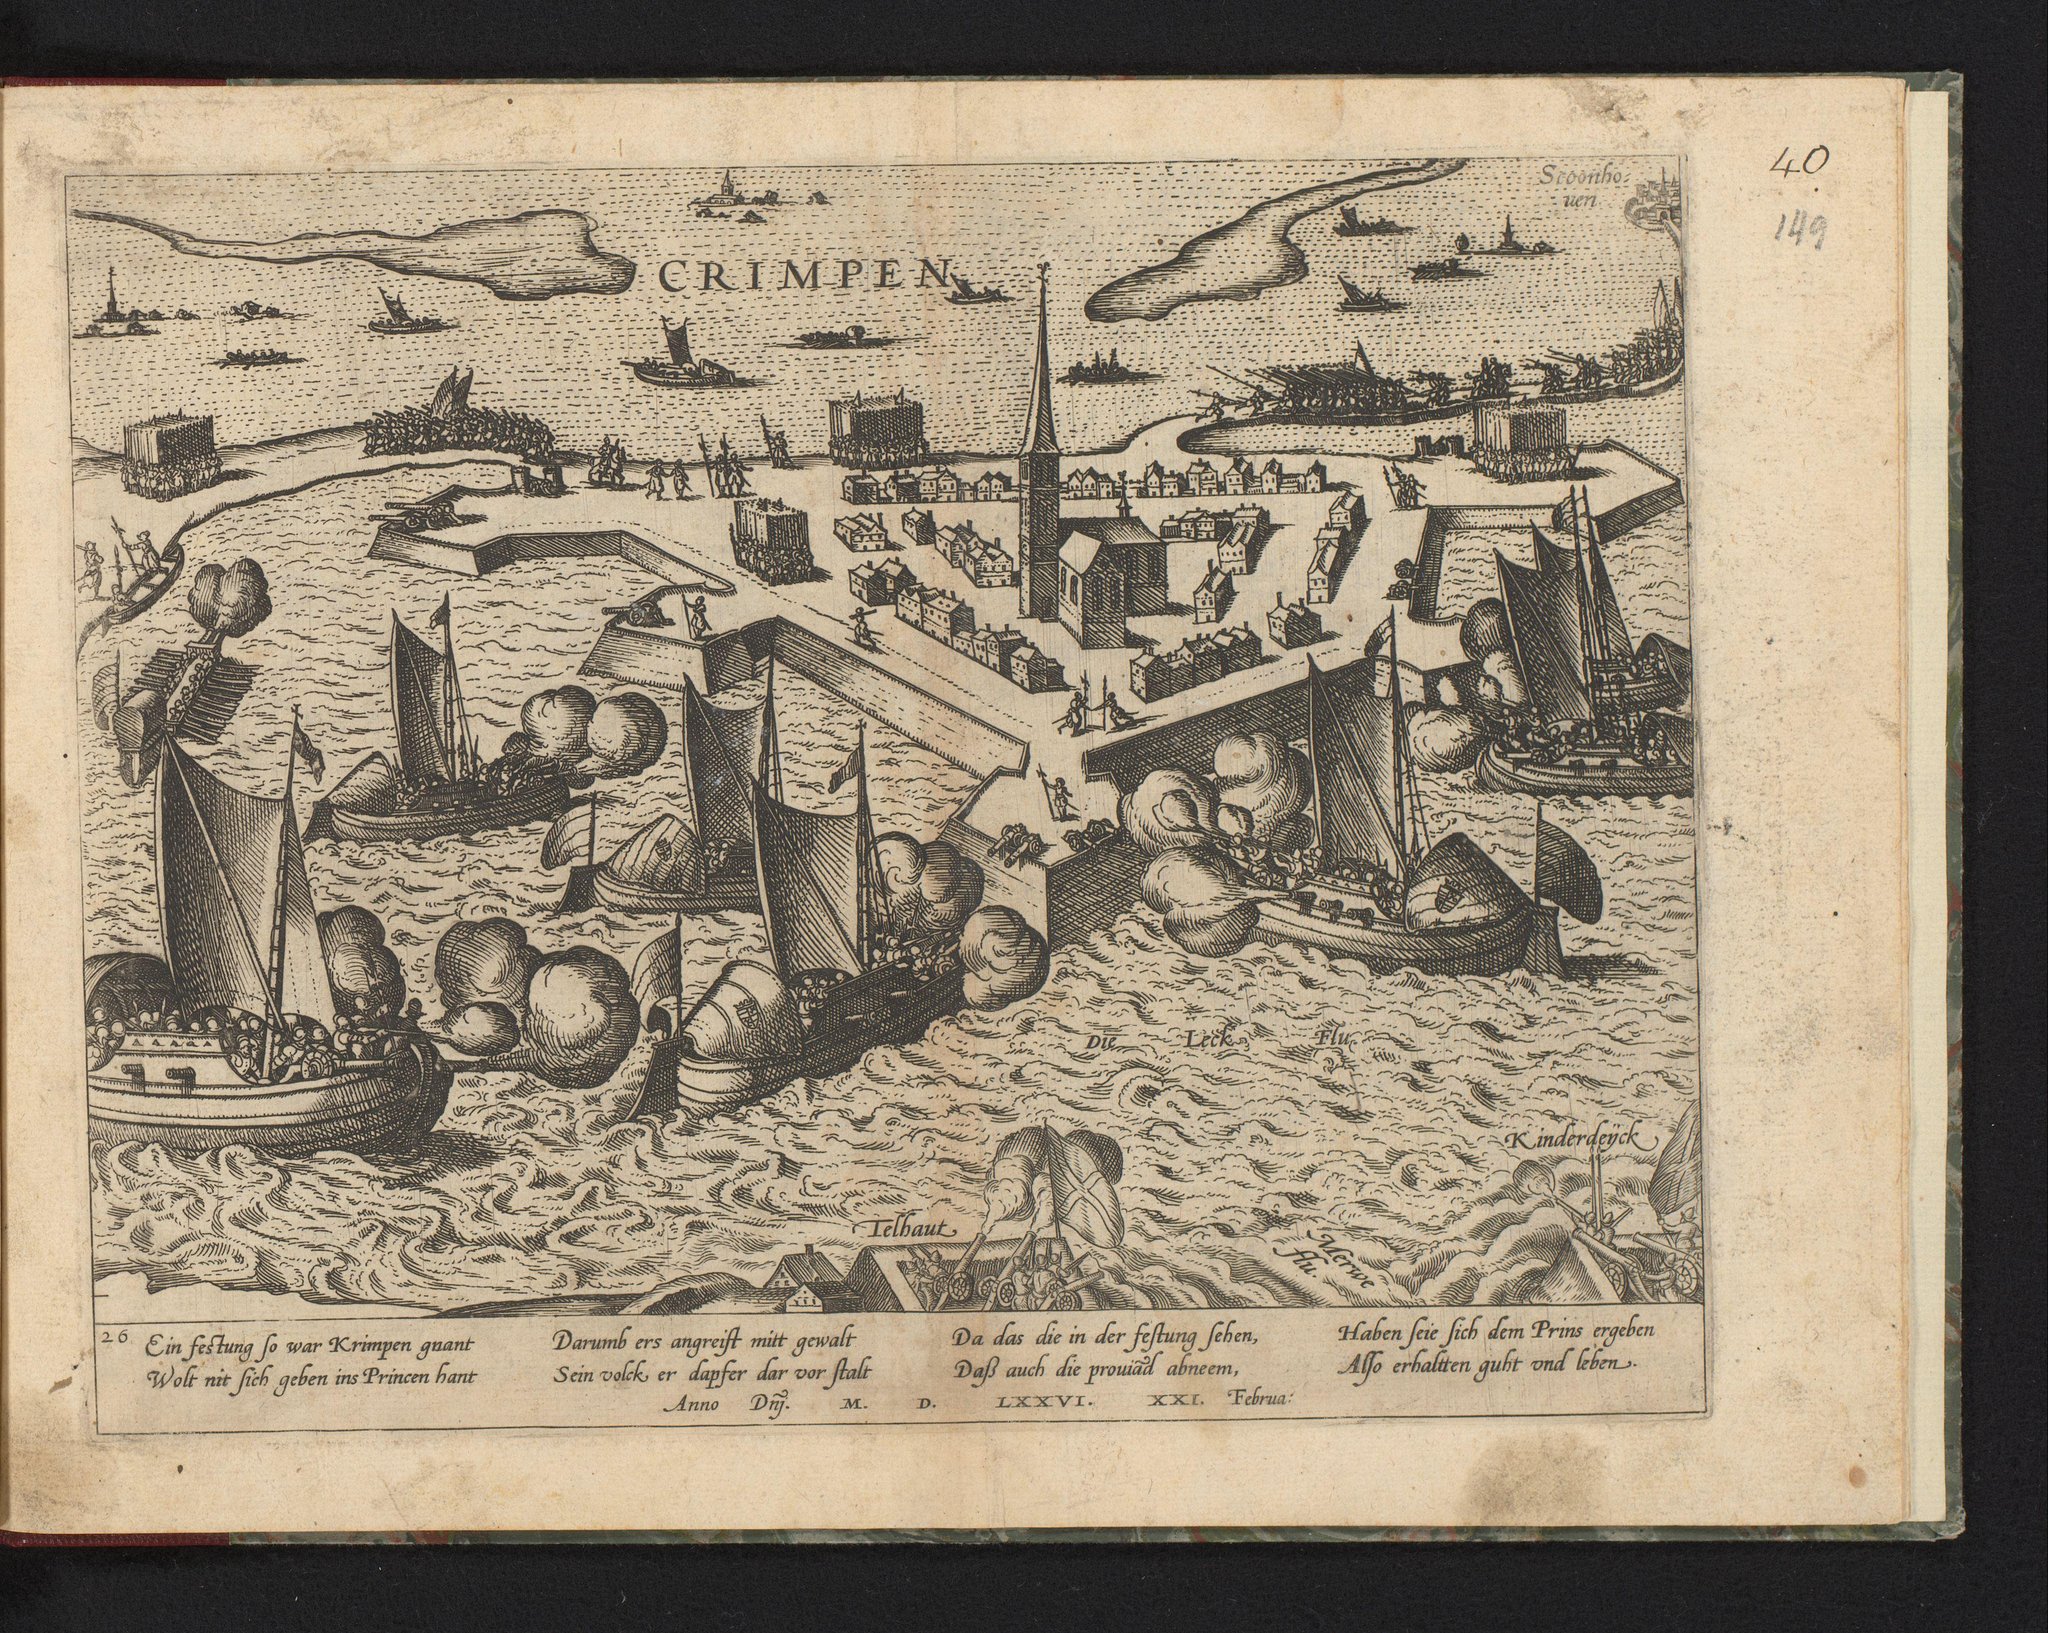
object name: print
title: Inname van Krimpen, 1576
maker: frans hogenberg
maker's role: print maker, publisher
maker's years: 1538-1590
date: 1576-1578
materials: paper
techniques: etching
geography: cologne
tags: siege, position war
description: Beleg van Krimpen aan de Lek door het leger van de prins. Schepen van de prins beschieten het versterkte stadje vanaf het water. Op 21 februari 1576 geeft Krimpen zich over. Met onderschrift van 8 regels in het Duits. Genummerd: 26. De prent maakt deel uit van een album.